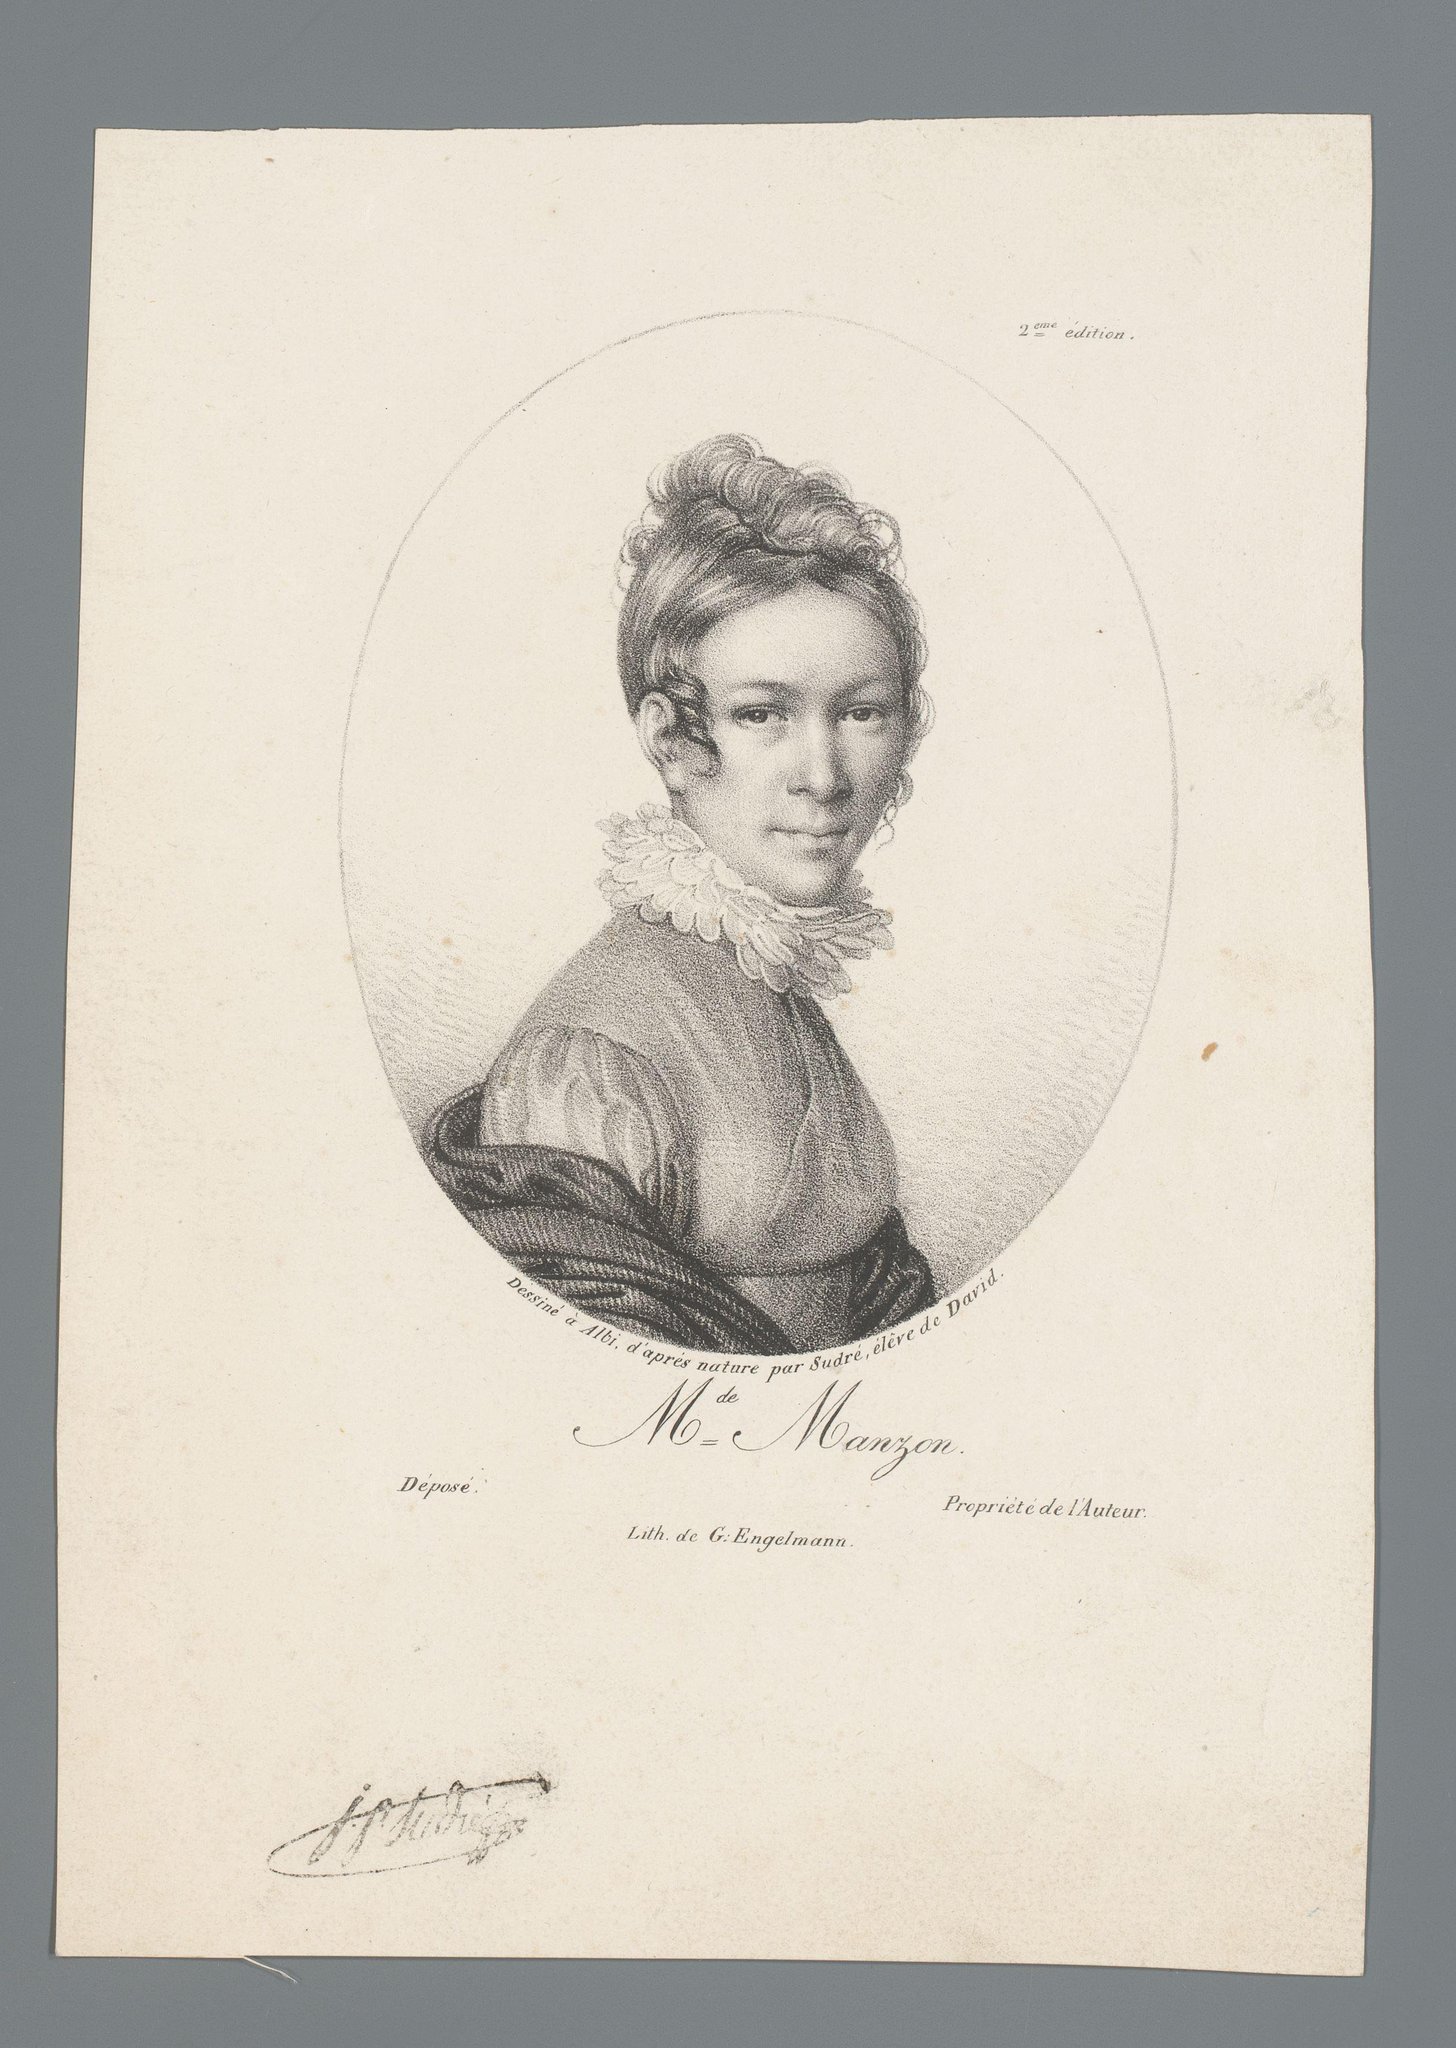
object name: print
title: Hoofdpersonages in de affaire-Fualdès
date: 1818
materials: paper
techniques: lithograph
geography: paris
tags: historical persons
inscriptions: stamp: Lugt 2325b, collector's mark: Lugt 2228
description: Eerste staat van deze prent bevat het volgende onderschrift: "Non de vils assassins je ne fus point complice, Francais vous me rendez au moins cette justice, Lisez dans mes regards et devinez mon cœur, avant de me blâmer vous plaindrez mon malheur". Zie: Bibliothèque Zoummeroff.